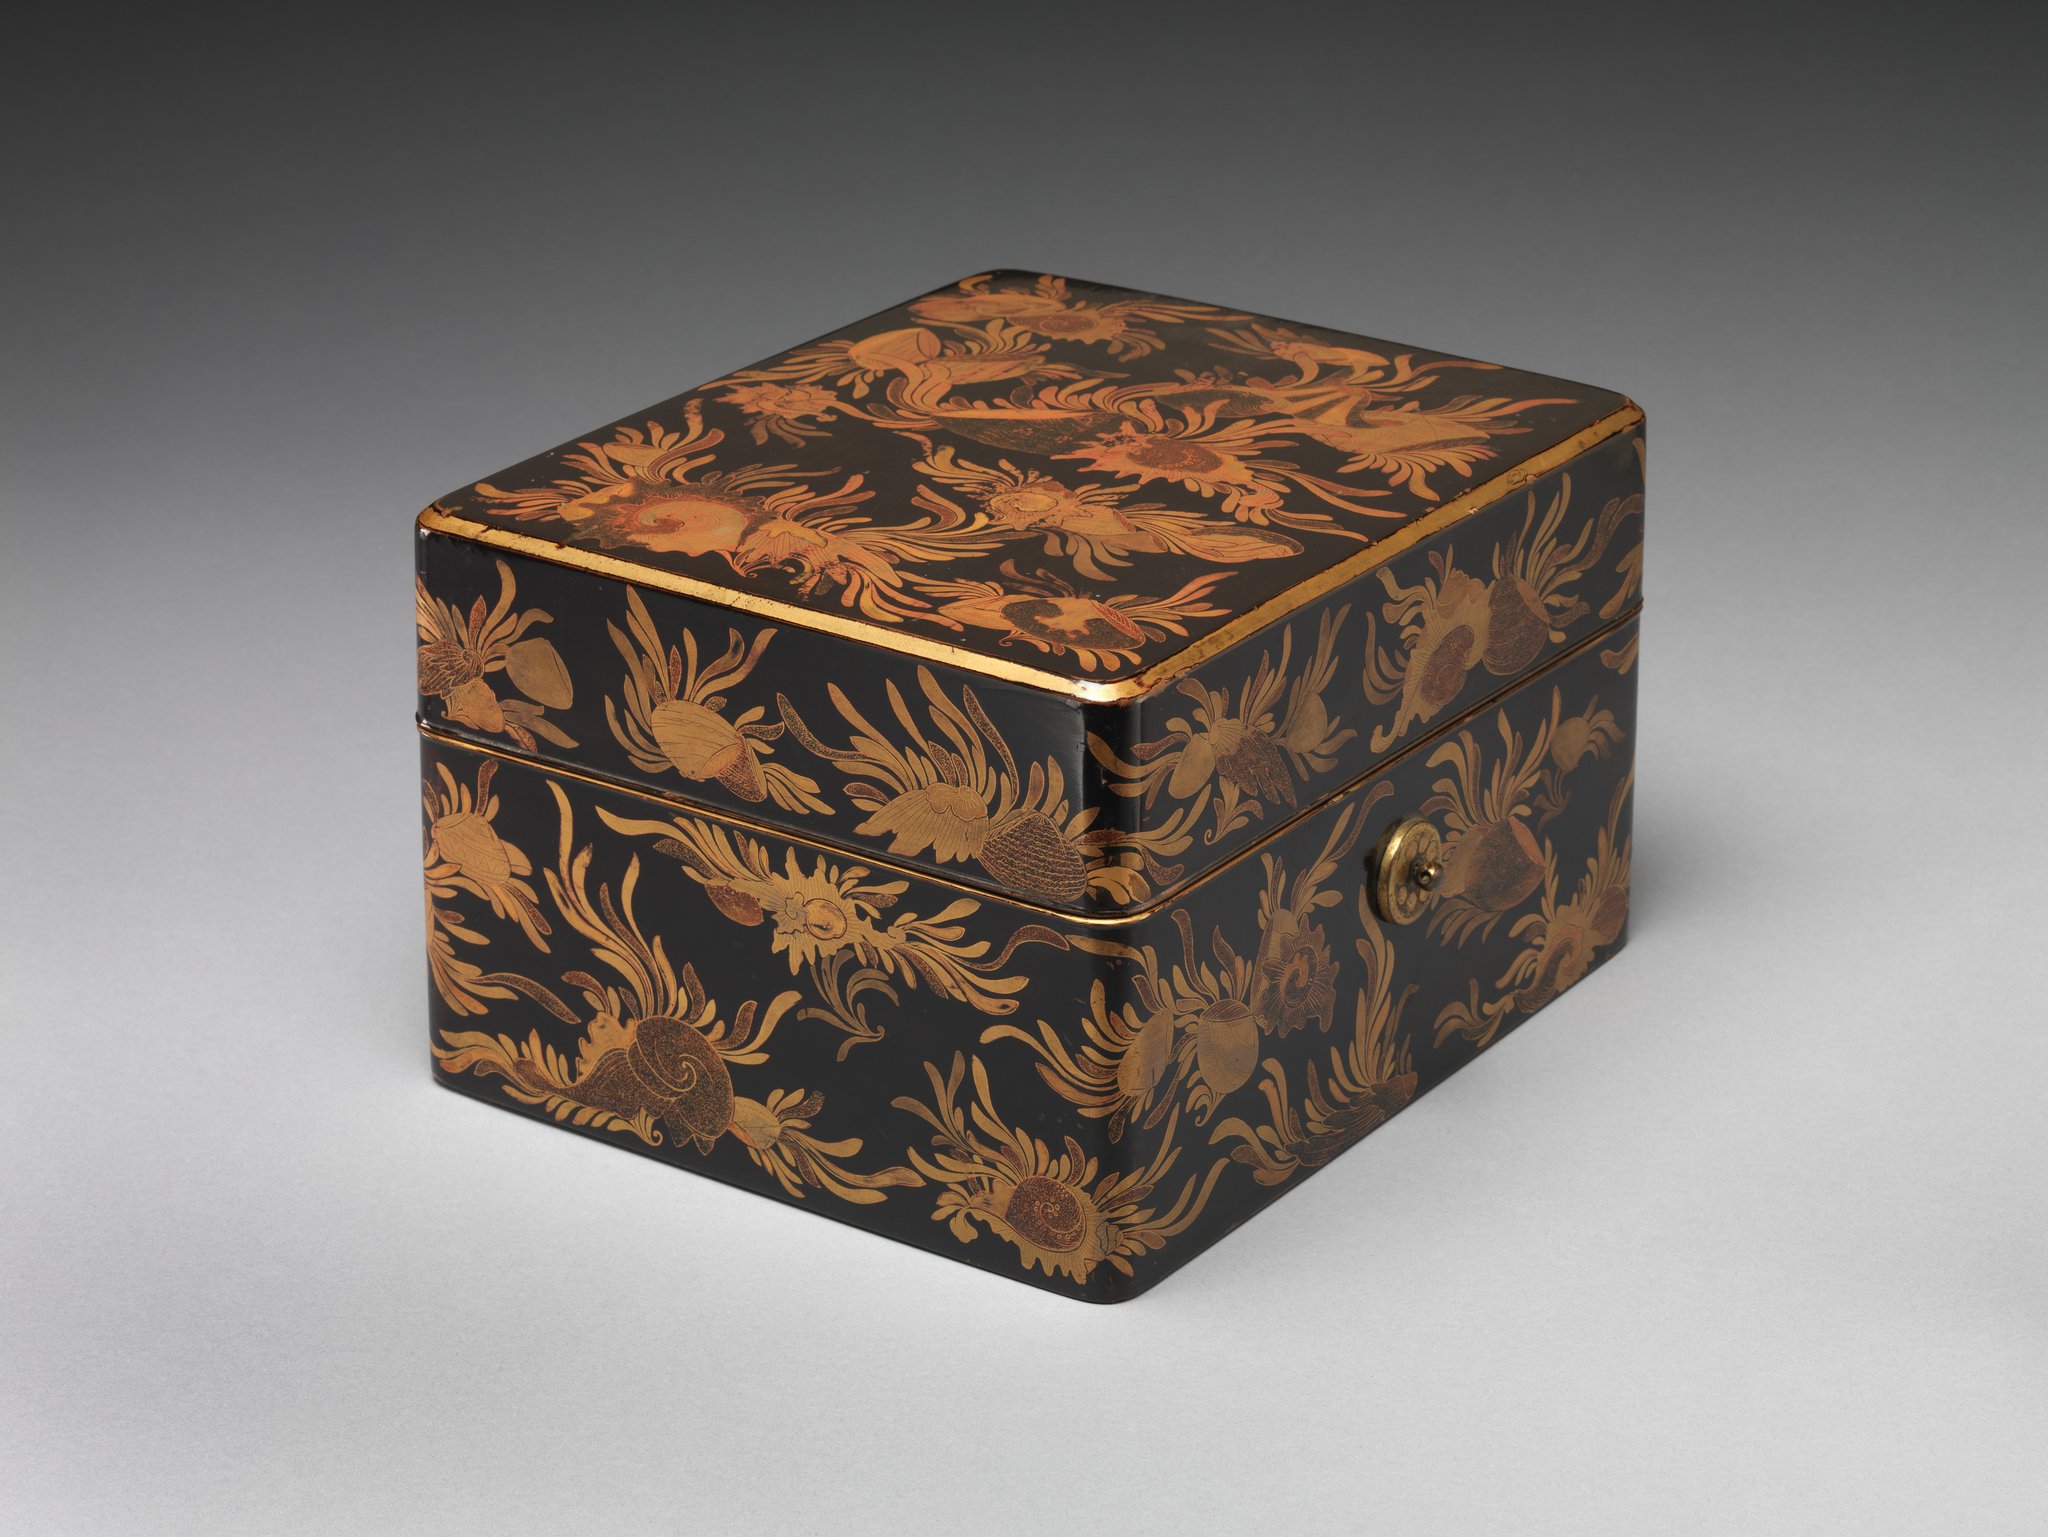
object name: box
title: Box for Personal Accessories (Tebako) with Shells and Seaweed Design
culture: japanese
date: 1601-1700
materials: gold, lacquer, wood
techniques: hiramakie, lacquer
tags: shells